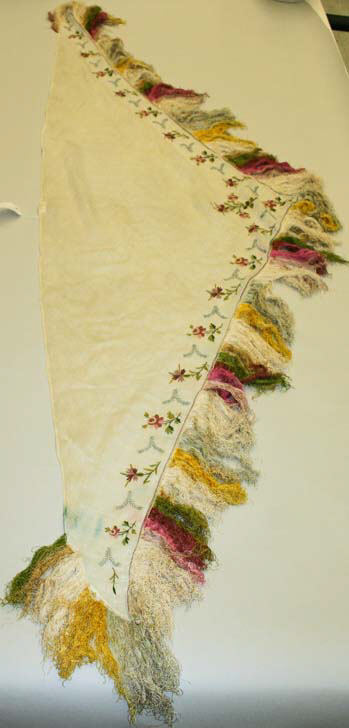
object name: shawl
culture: french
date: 1814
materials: cotton, silk